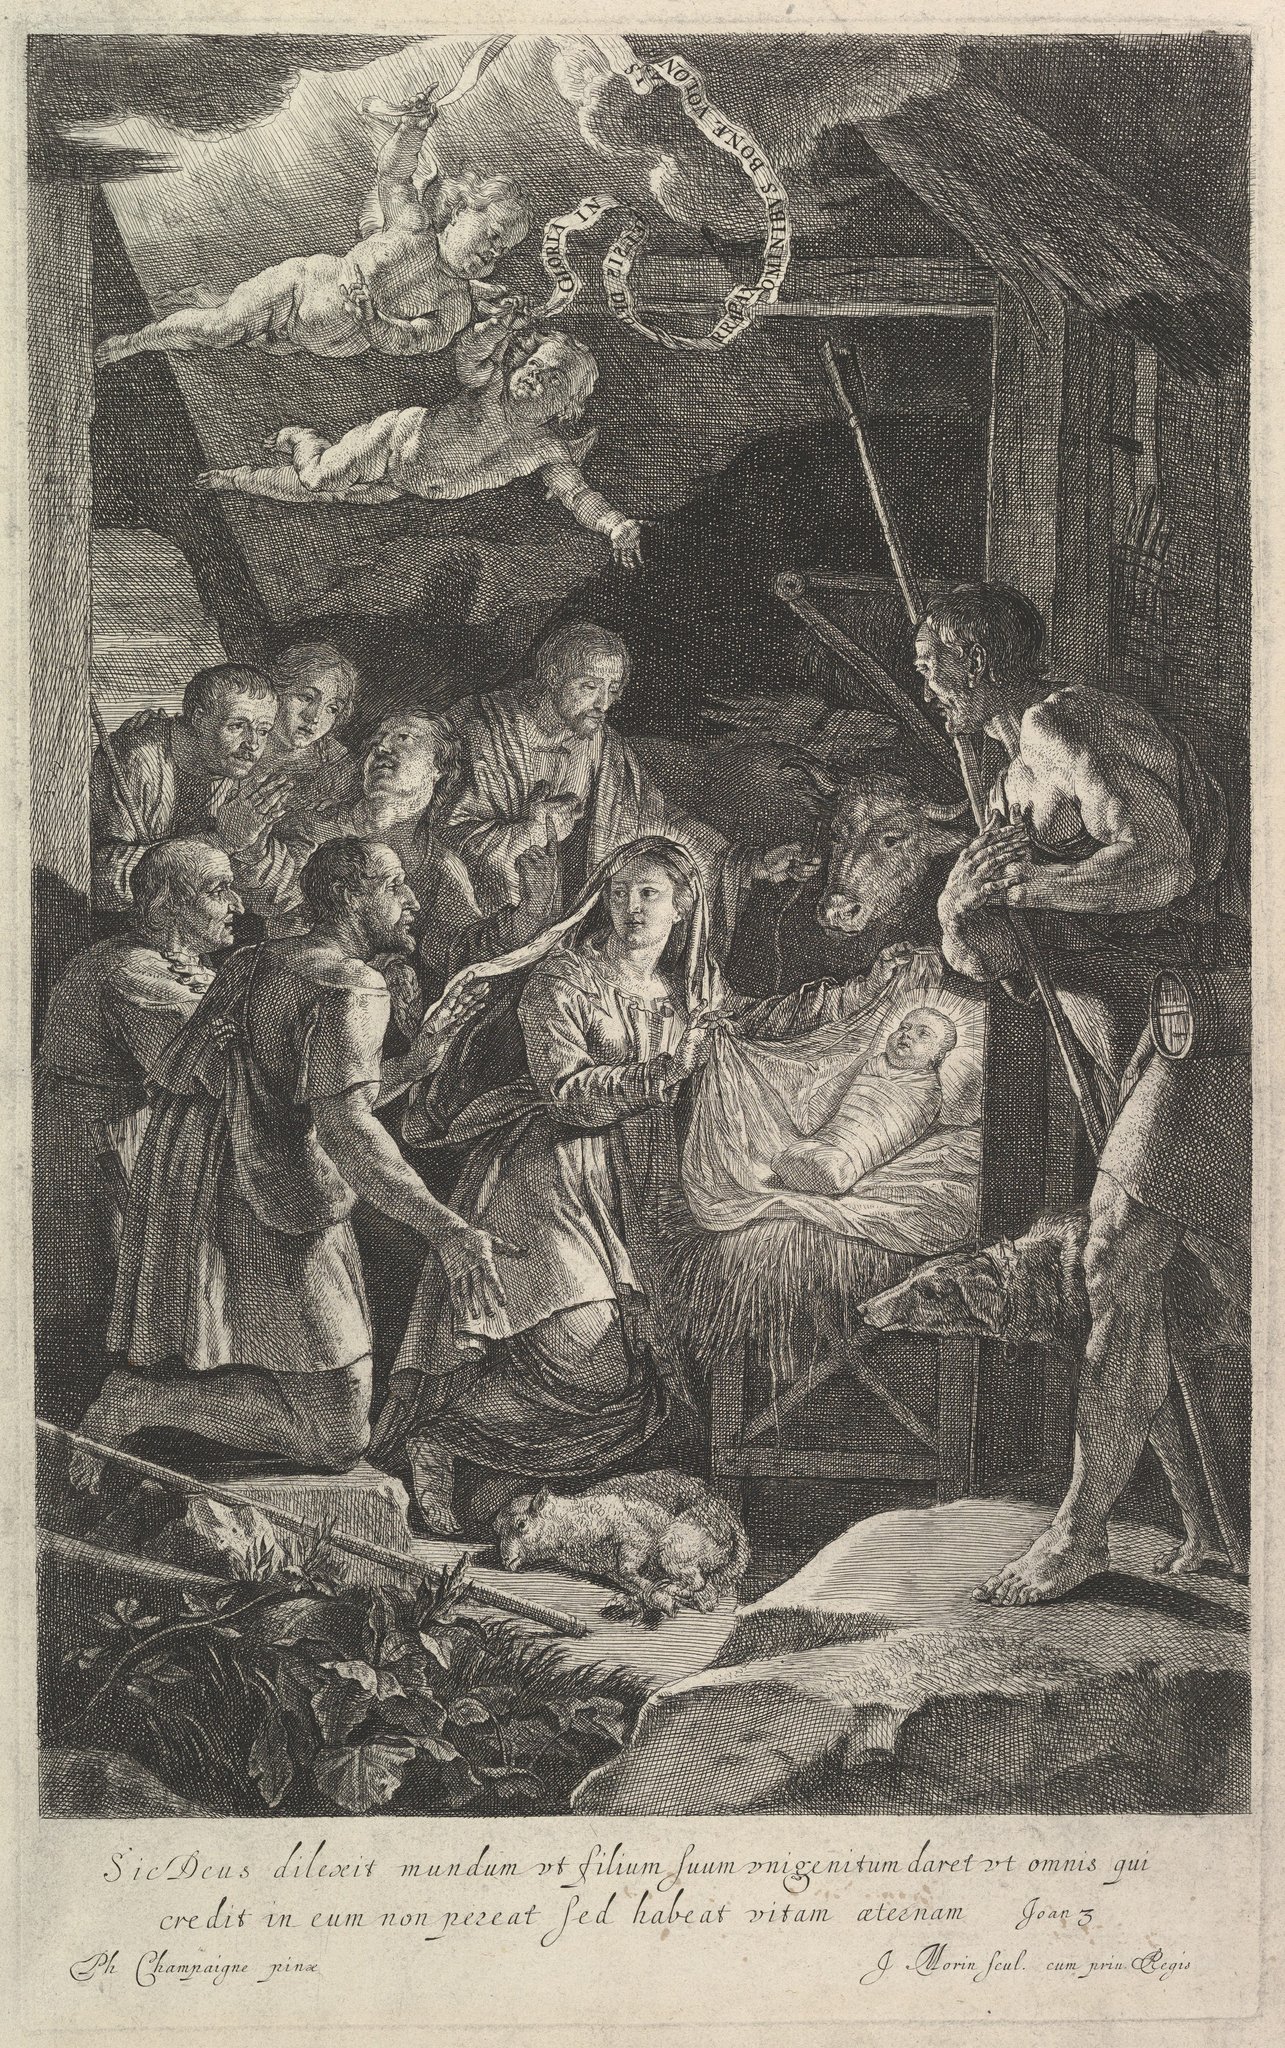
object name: print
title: L'adoration des bergers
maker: jean morin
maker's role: artist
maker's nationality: french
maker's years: 1605-1650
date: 1605-1650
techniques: etching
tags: men,women,cupid,sheep